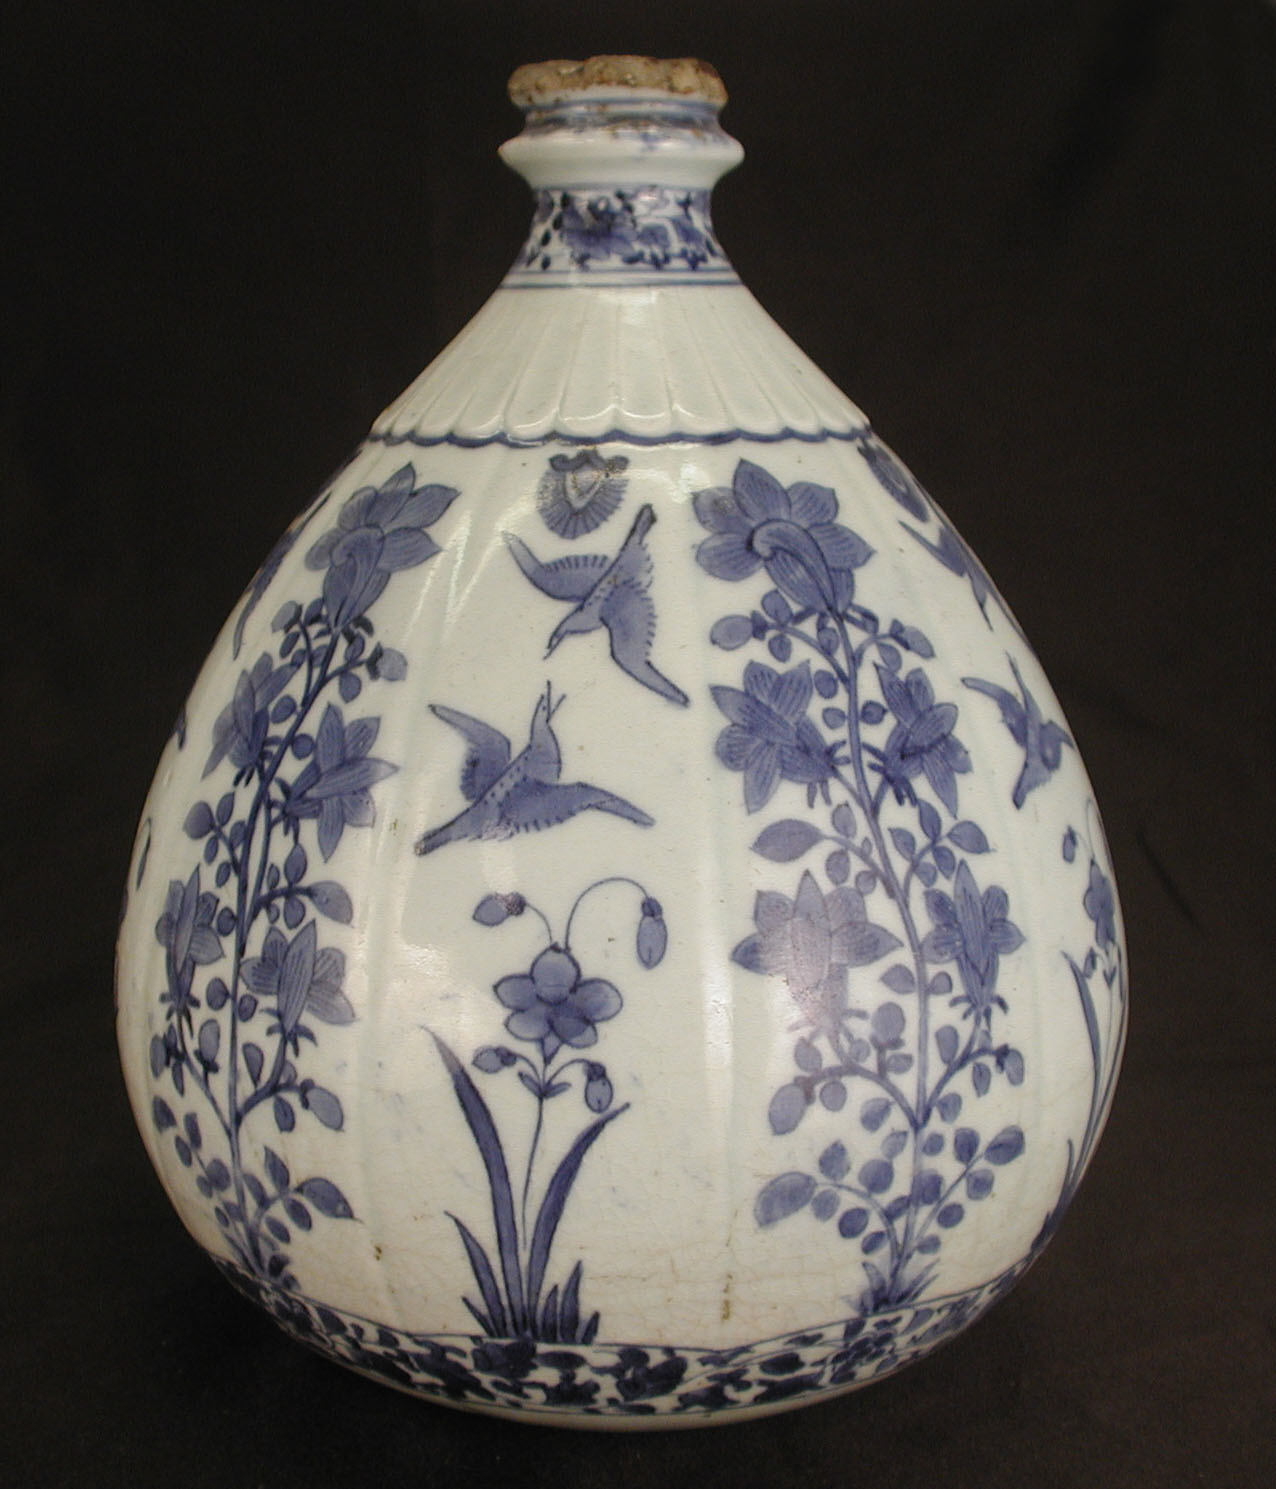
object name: vase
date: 1601-1700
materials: glaze, stonepaste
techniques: painting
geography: iran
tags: birds,flowers